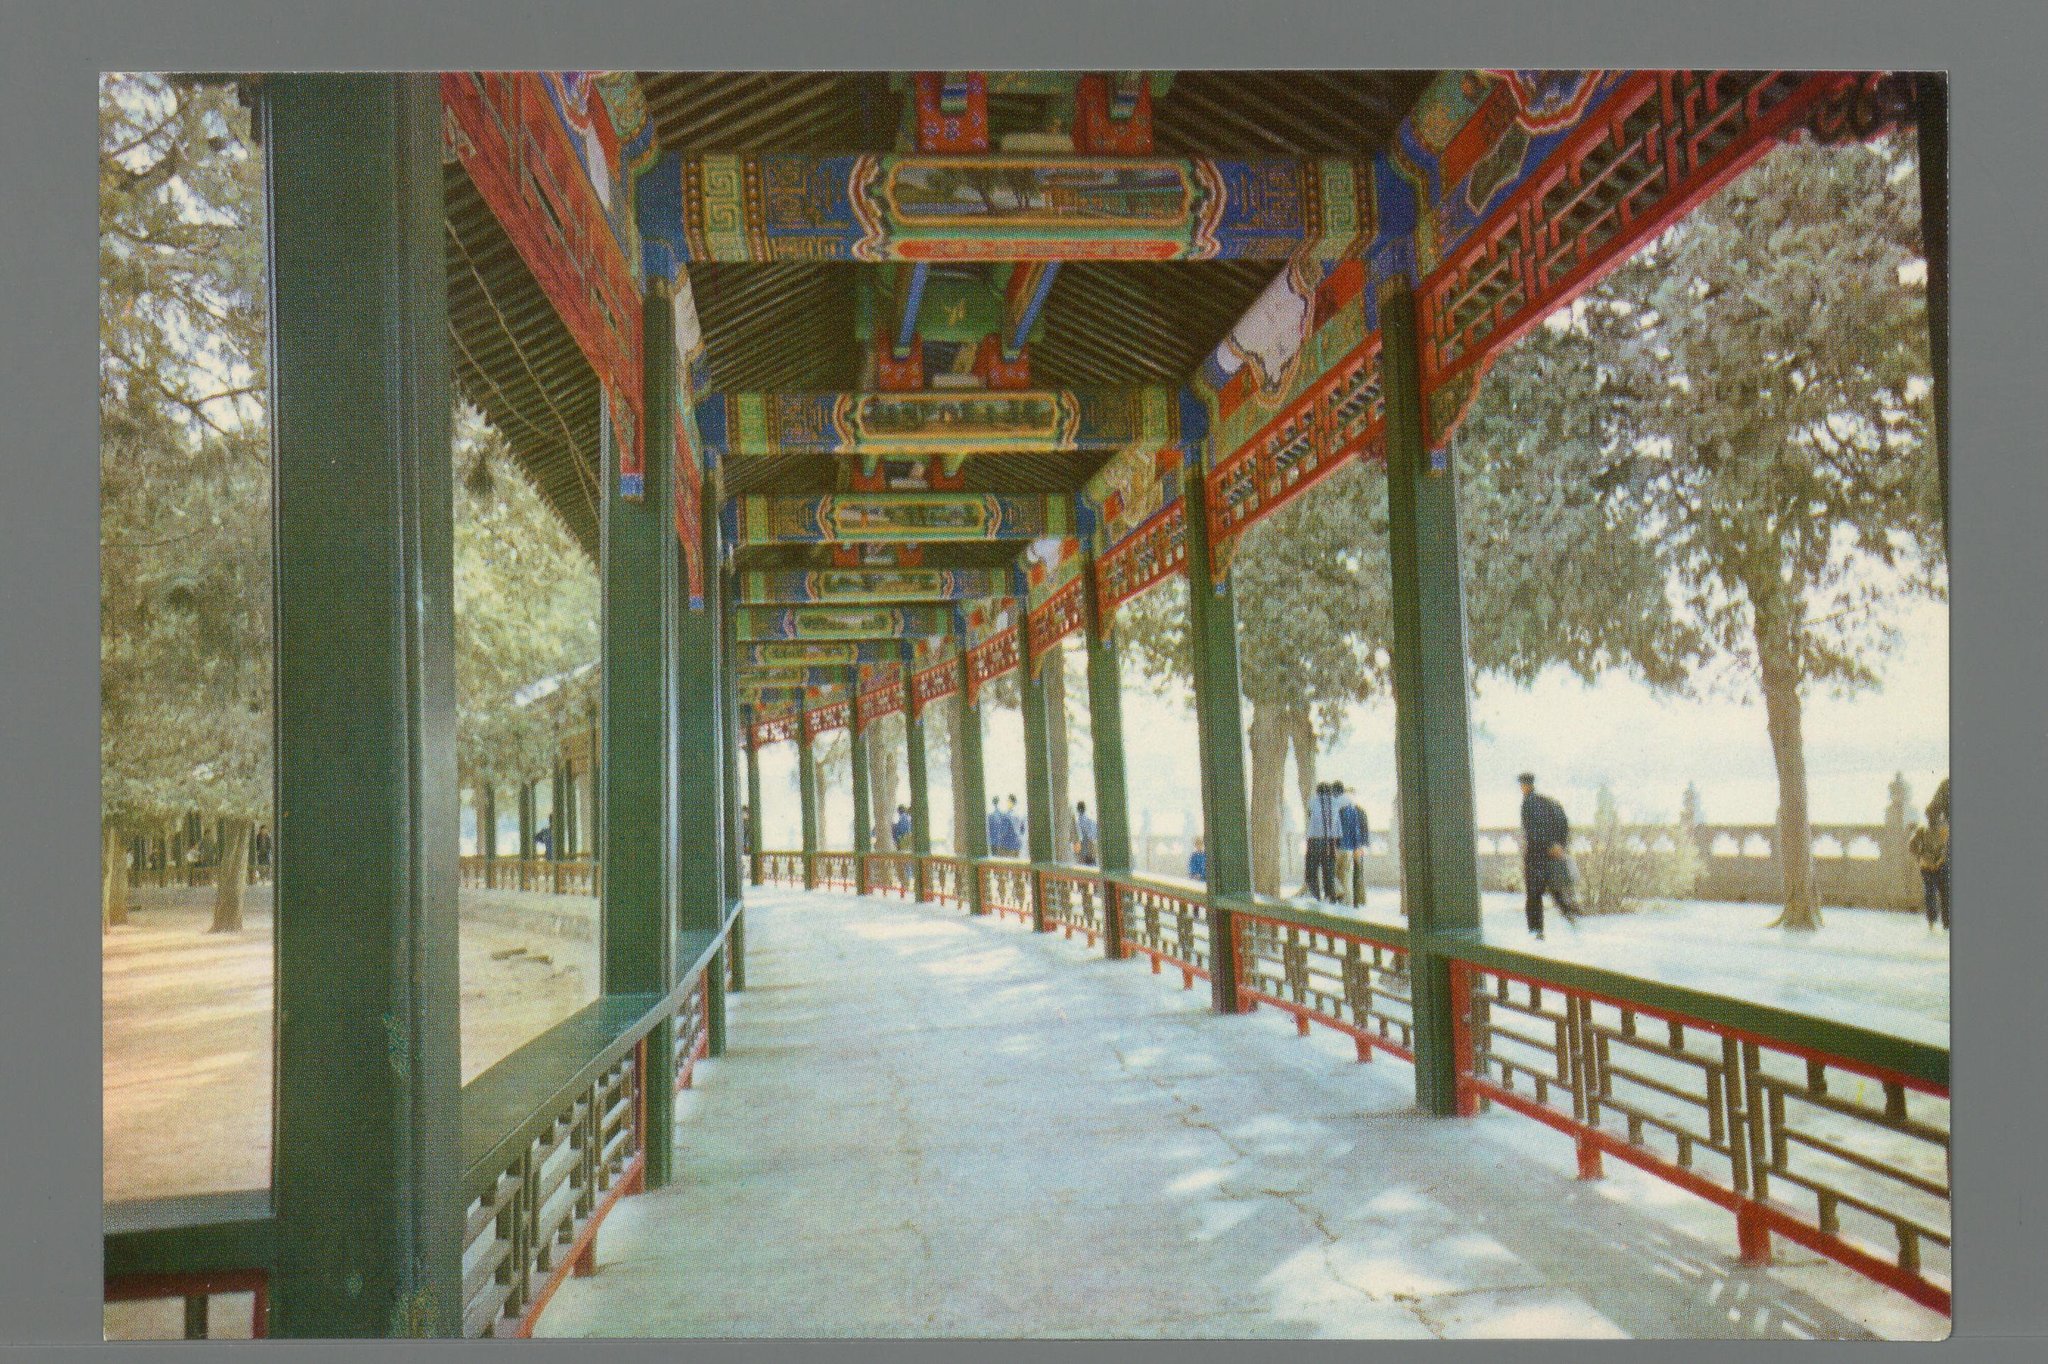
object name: photomechanical print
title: The Summer Palace, Peking / Vues du Palais d'Eté de Pékin / Vista del Palacio de Verano, Pekin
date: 1974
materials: cardboard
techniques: offset printed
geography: beijing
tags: palace, avenue, boulevard, promenade, esplanade